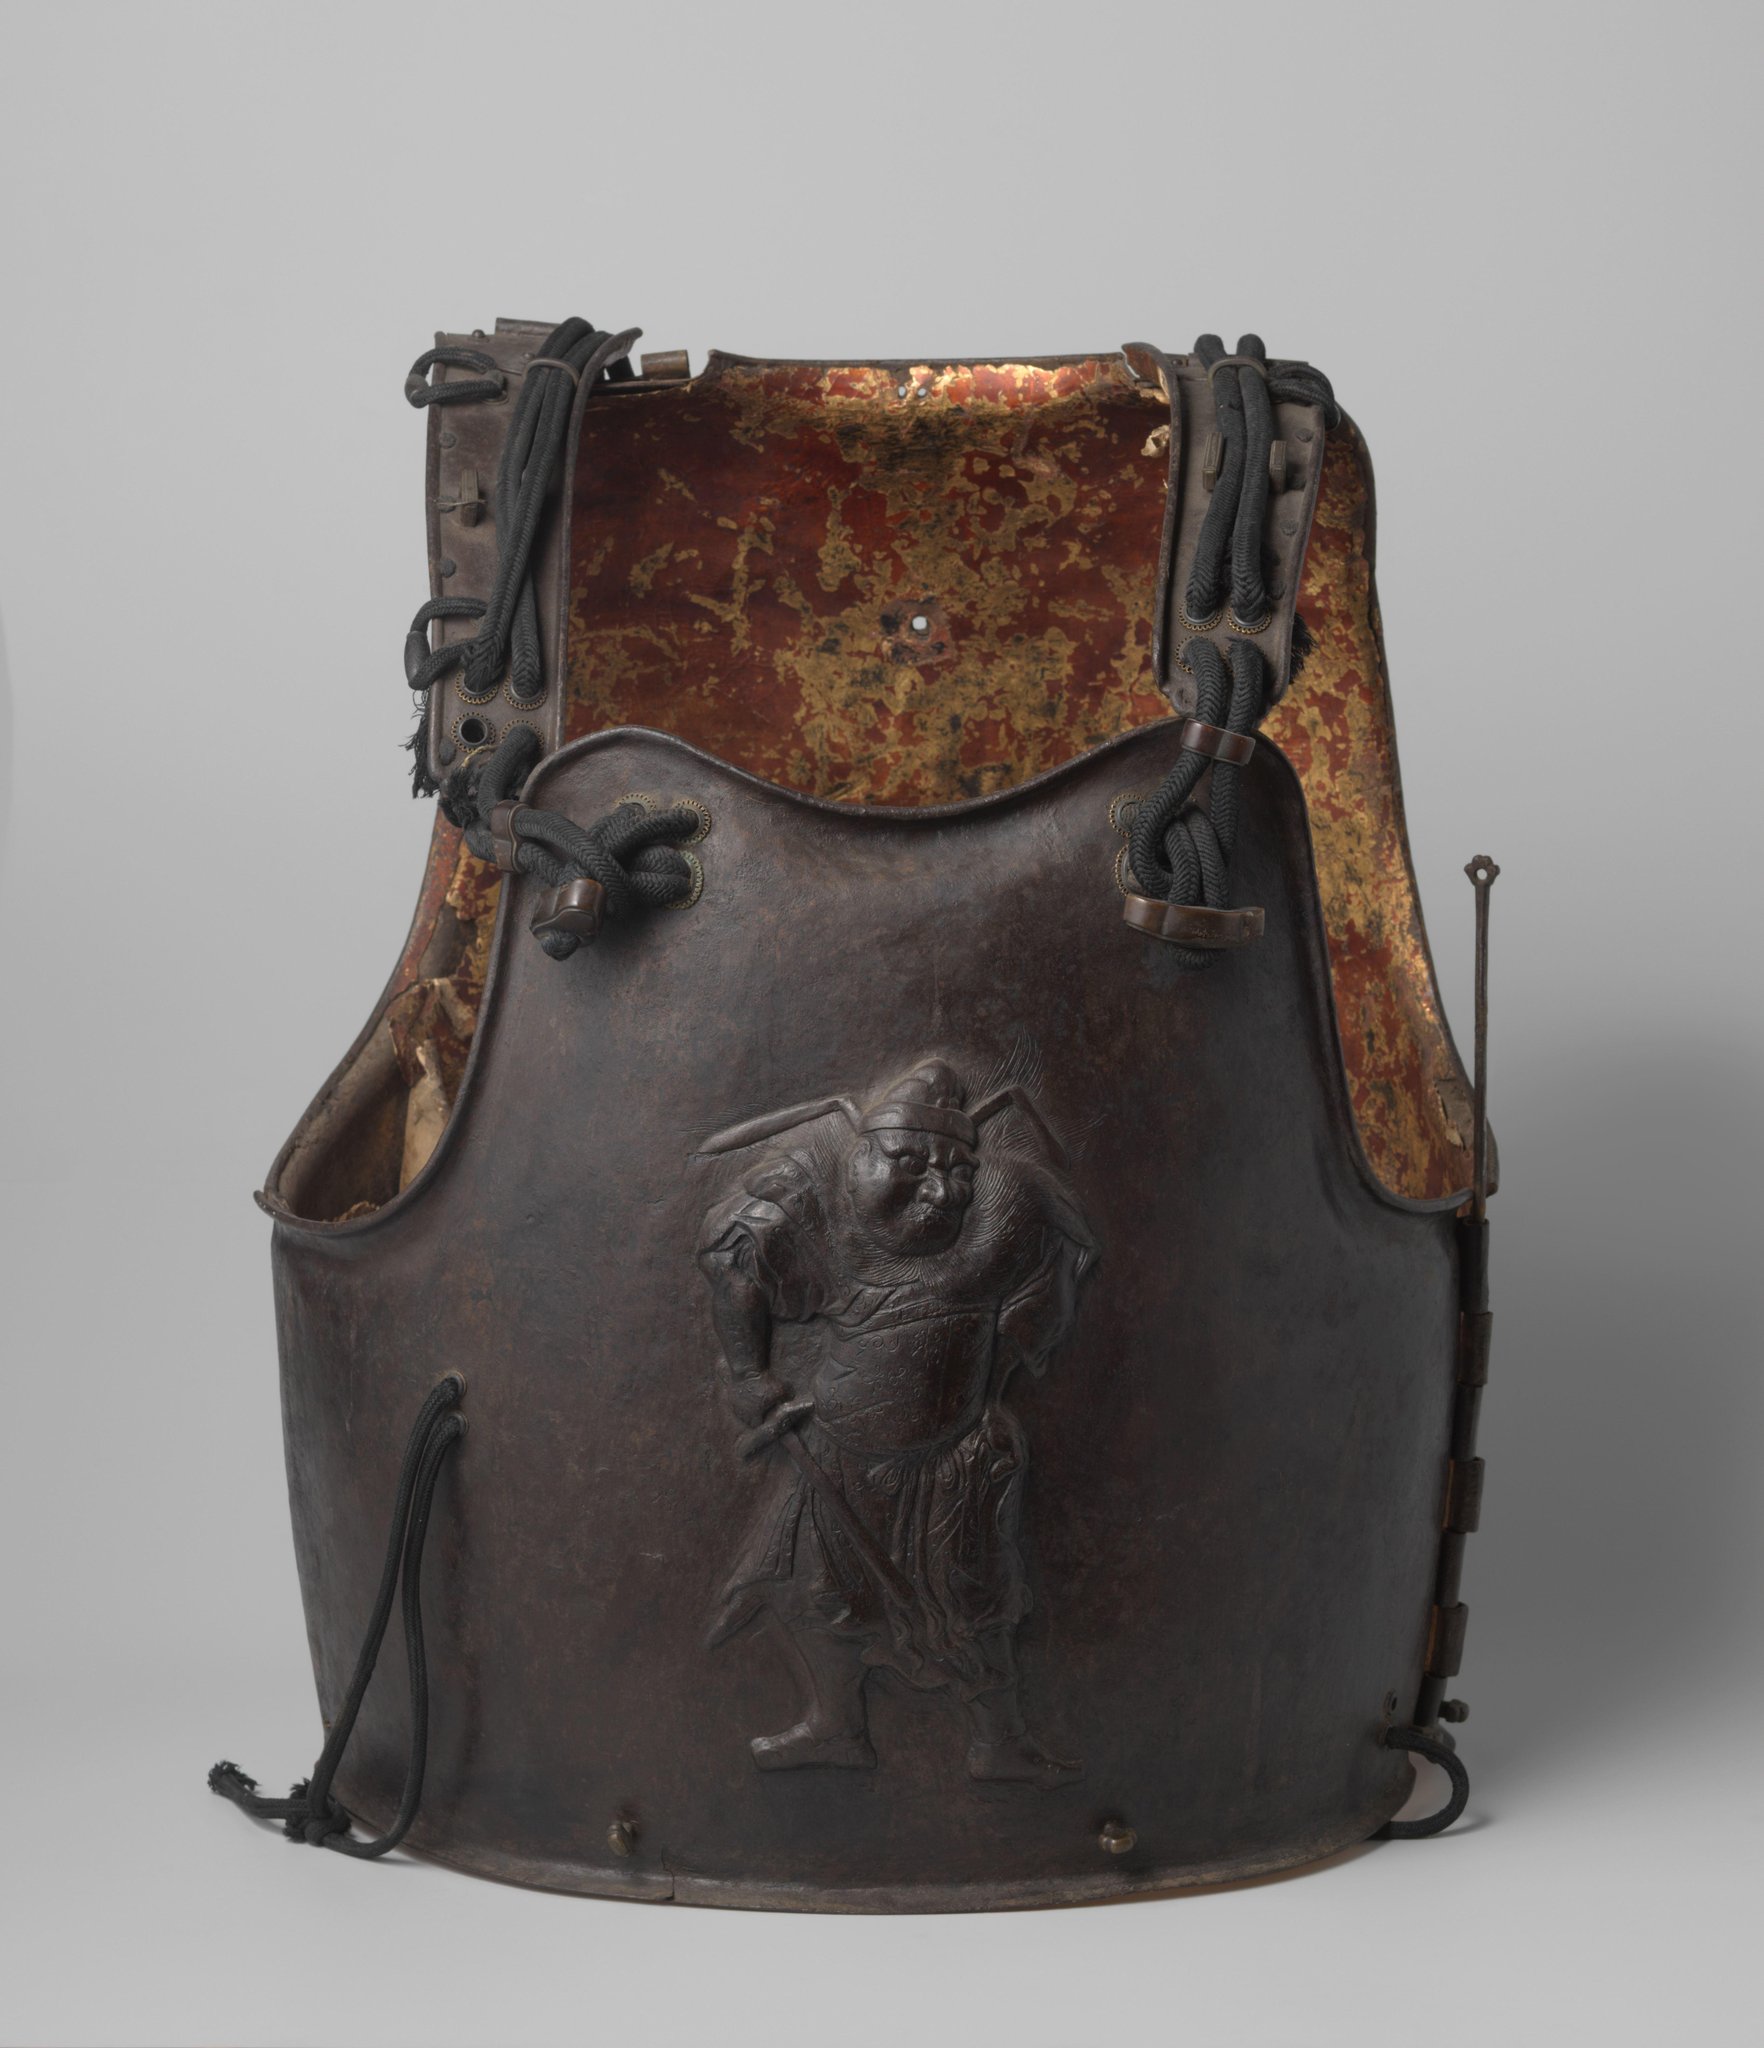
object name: armor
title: Bovenstuk van een wapenrusting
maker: Anonymous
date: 1699-1799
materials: metal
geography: japan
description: Breastplate and sleeves of a suit of armour showing the Satake family crest. Japan. 17th or 18th century. Iron, with silver, gold and copper inlay.